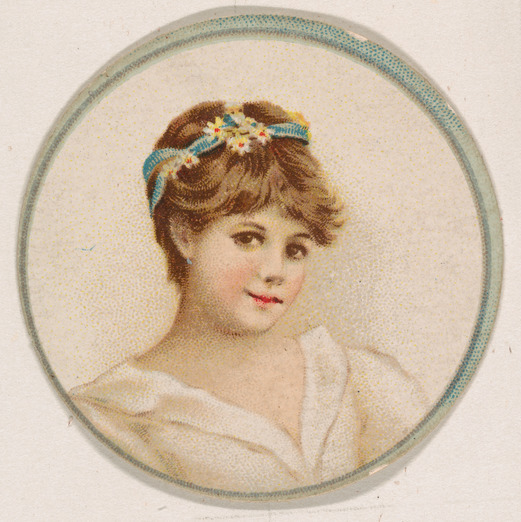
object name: print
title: Portrait of woman, from the Novelties series (N228, Type 2) issued by Kinney Bros.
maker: kinney brothers tobacco company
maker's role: publisher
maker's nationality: american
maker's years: 1869-2011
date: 1889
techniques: color lithograph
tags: portraits,women